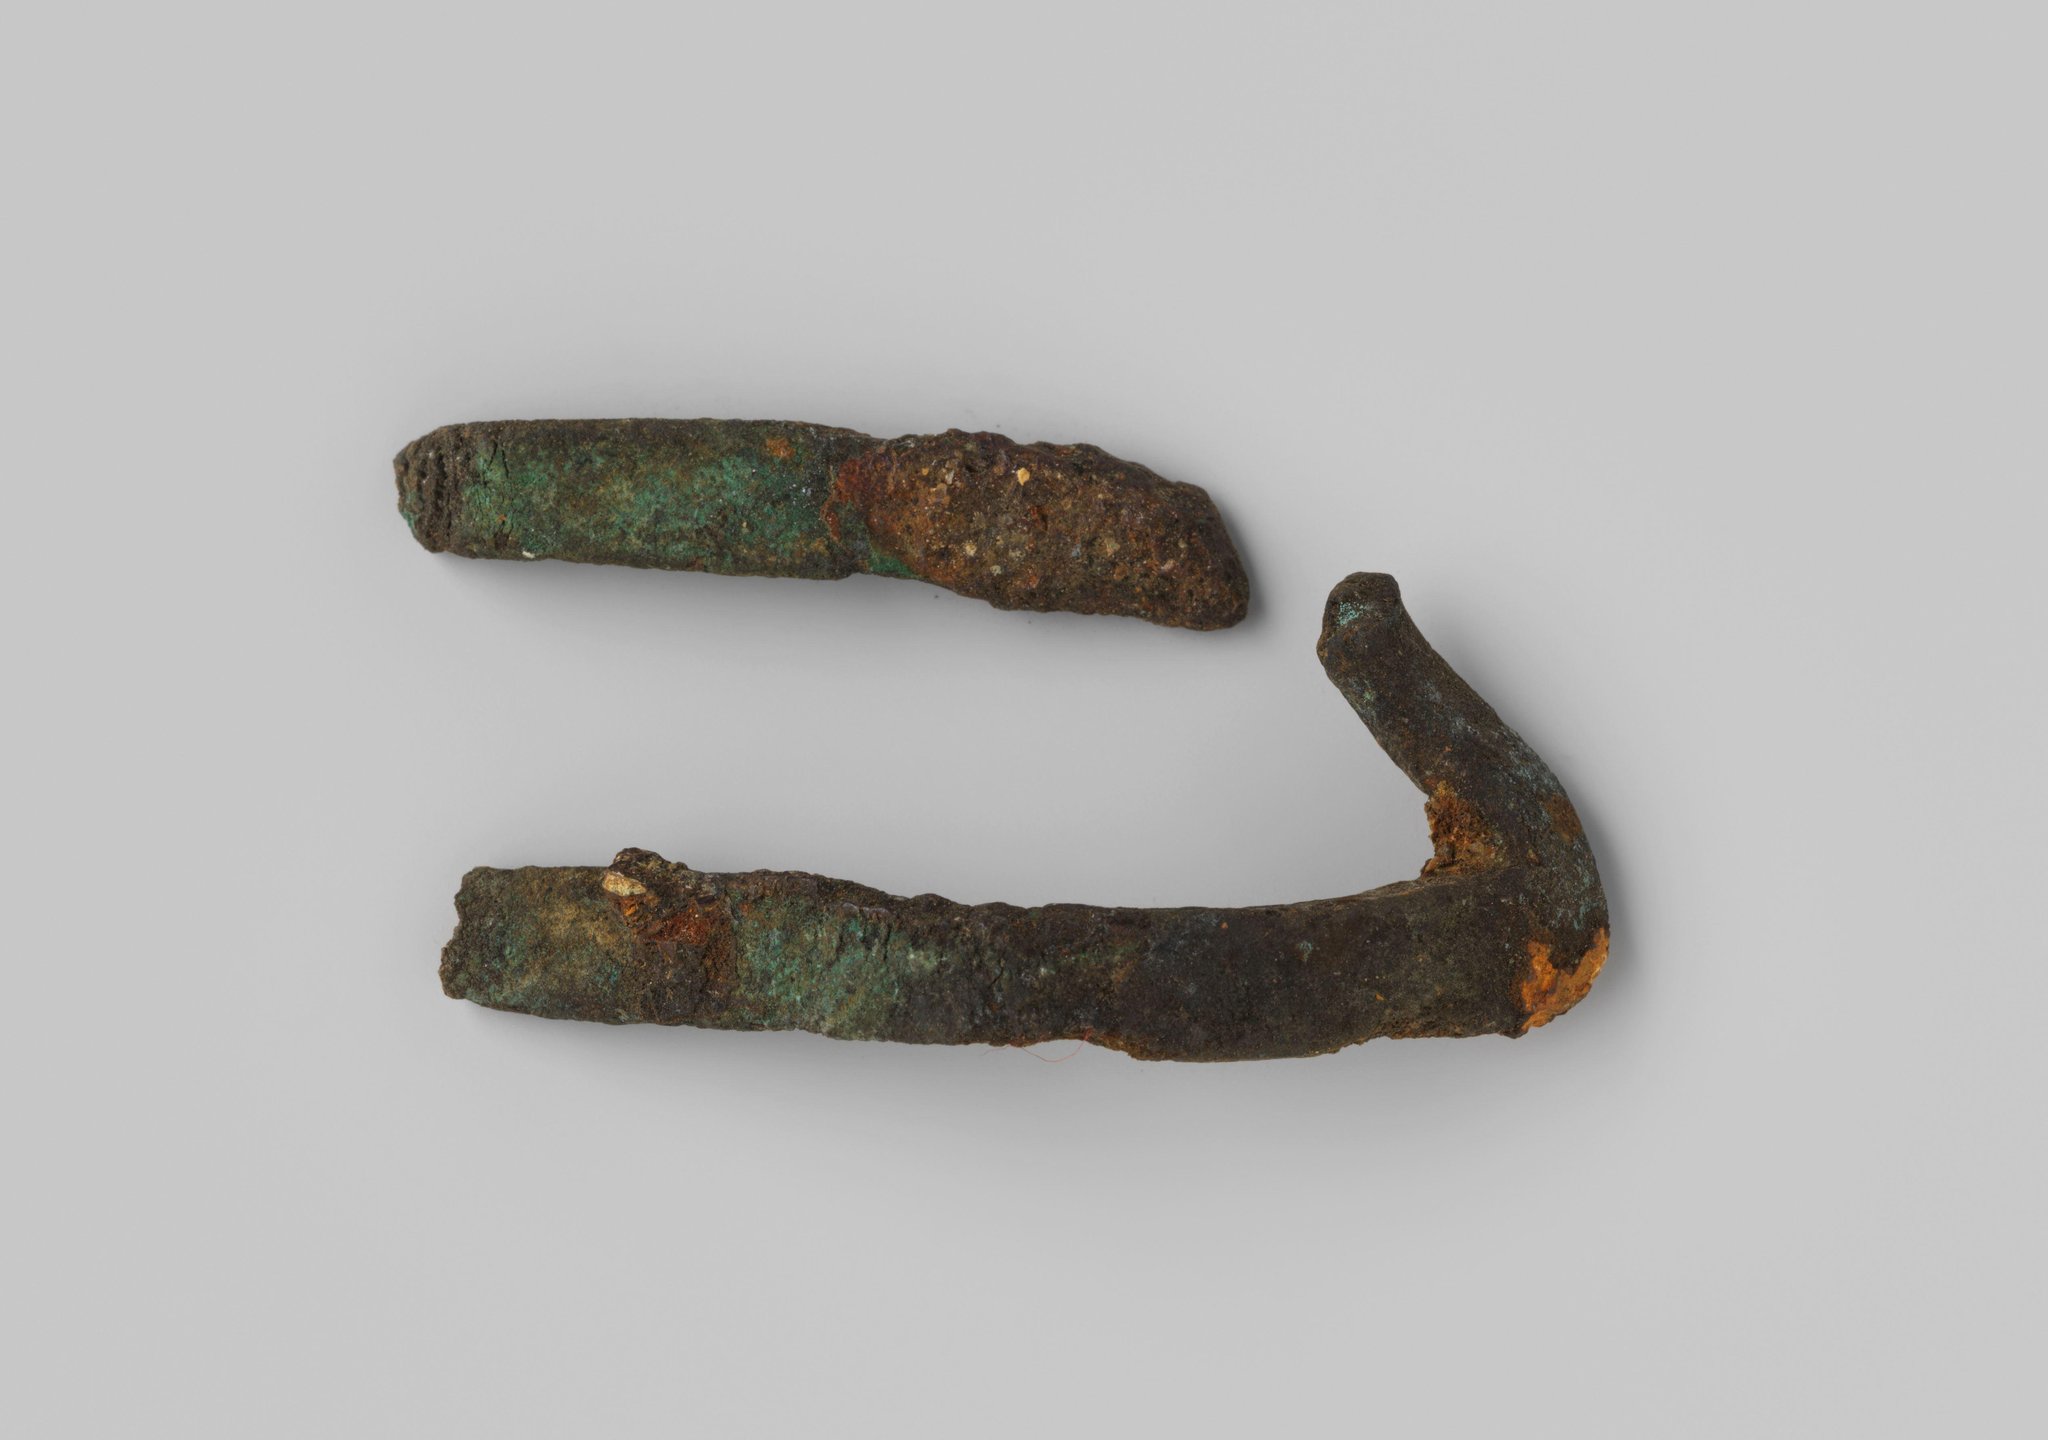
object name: belt buckle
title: Fragmenten riemgesp uit het wrak van de Oost-Indiëvaarder Hollandia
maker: Anonymous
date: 1700-1743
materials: copper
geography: netherlands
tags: verenigde oostindische compagnie, hollandia (schip), annet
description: Rectangular, fragm of ring, id. NG 1980-27H2852, belt buckle.